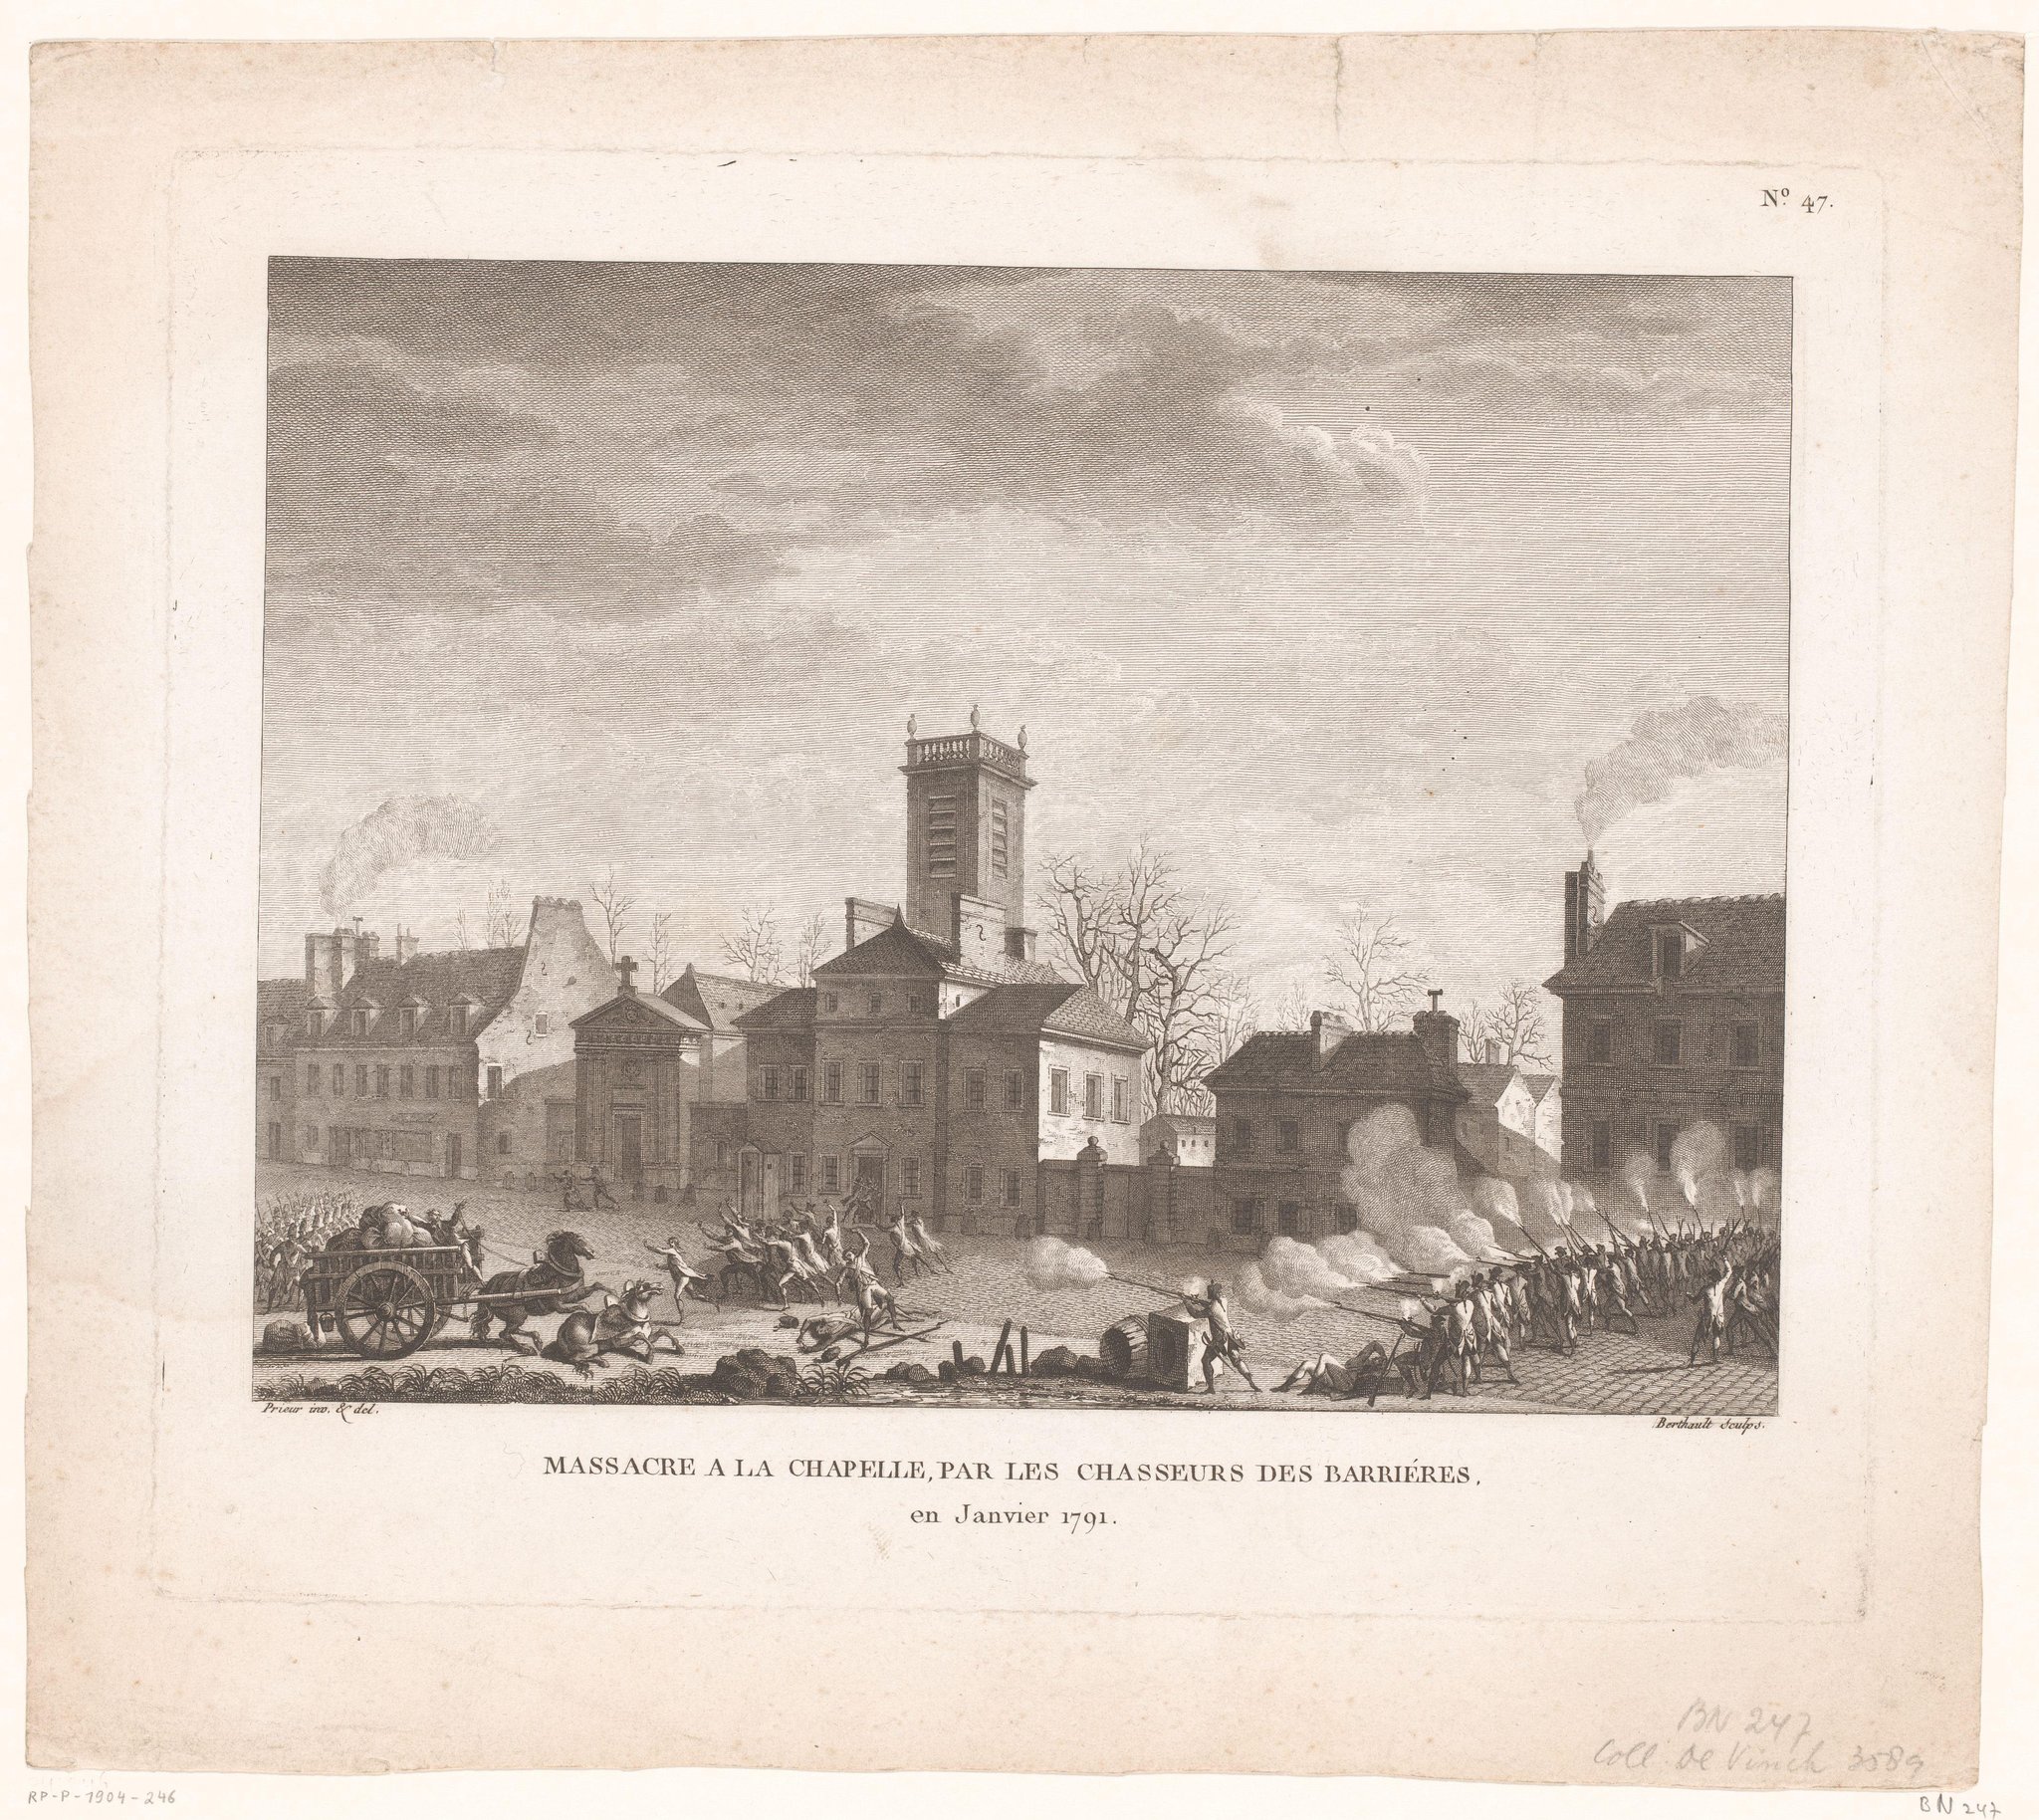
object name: print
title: Gewelddadige confrontatie voor een kapel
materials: paper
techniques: etching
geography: france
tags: church (exterior) - qq - small church, chapel, massacre ~ war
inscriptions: collector's mark: Lugt 2228